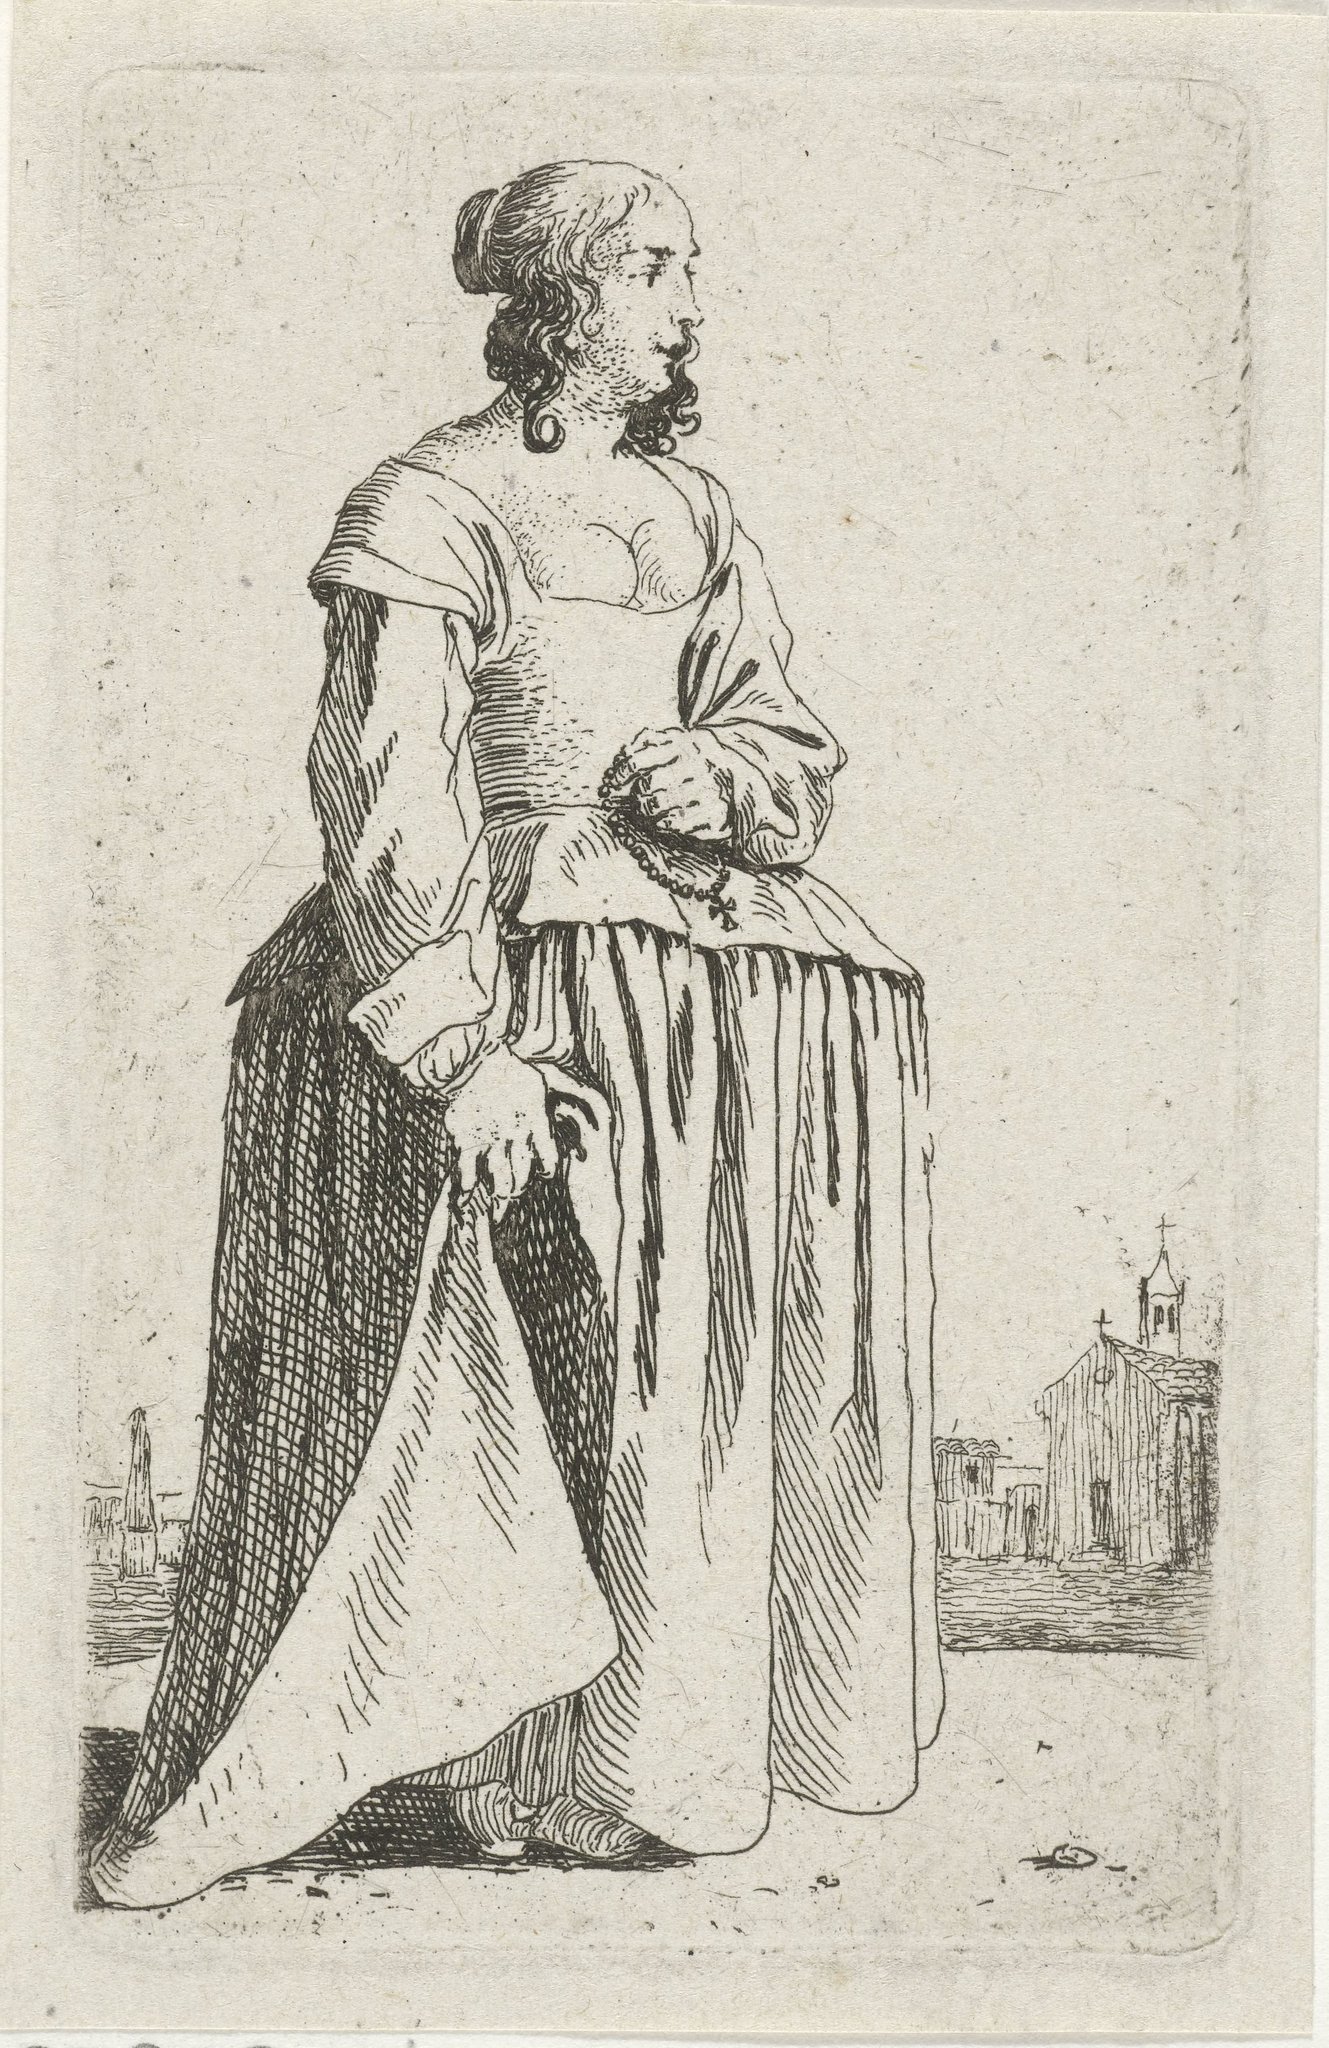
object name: print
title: Dame naar rechts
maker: jan van den hecke (ii)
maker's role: print maker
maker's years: 1661-1722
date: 1671-1710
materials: paper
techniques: etching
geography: southern netherlands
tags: adult woman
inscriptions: collector's mark: Lugt 240